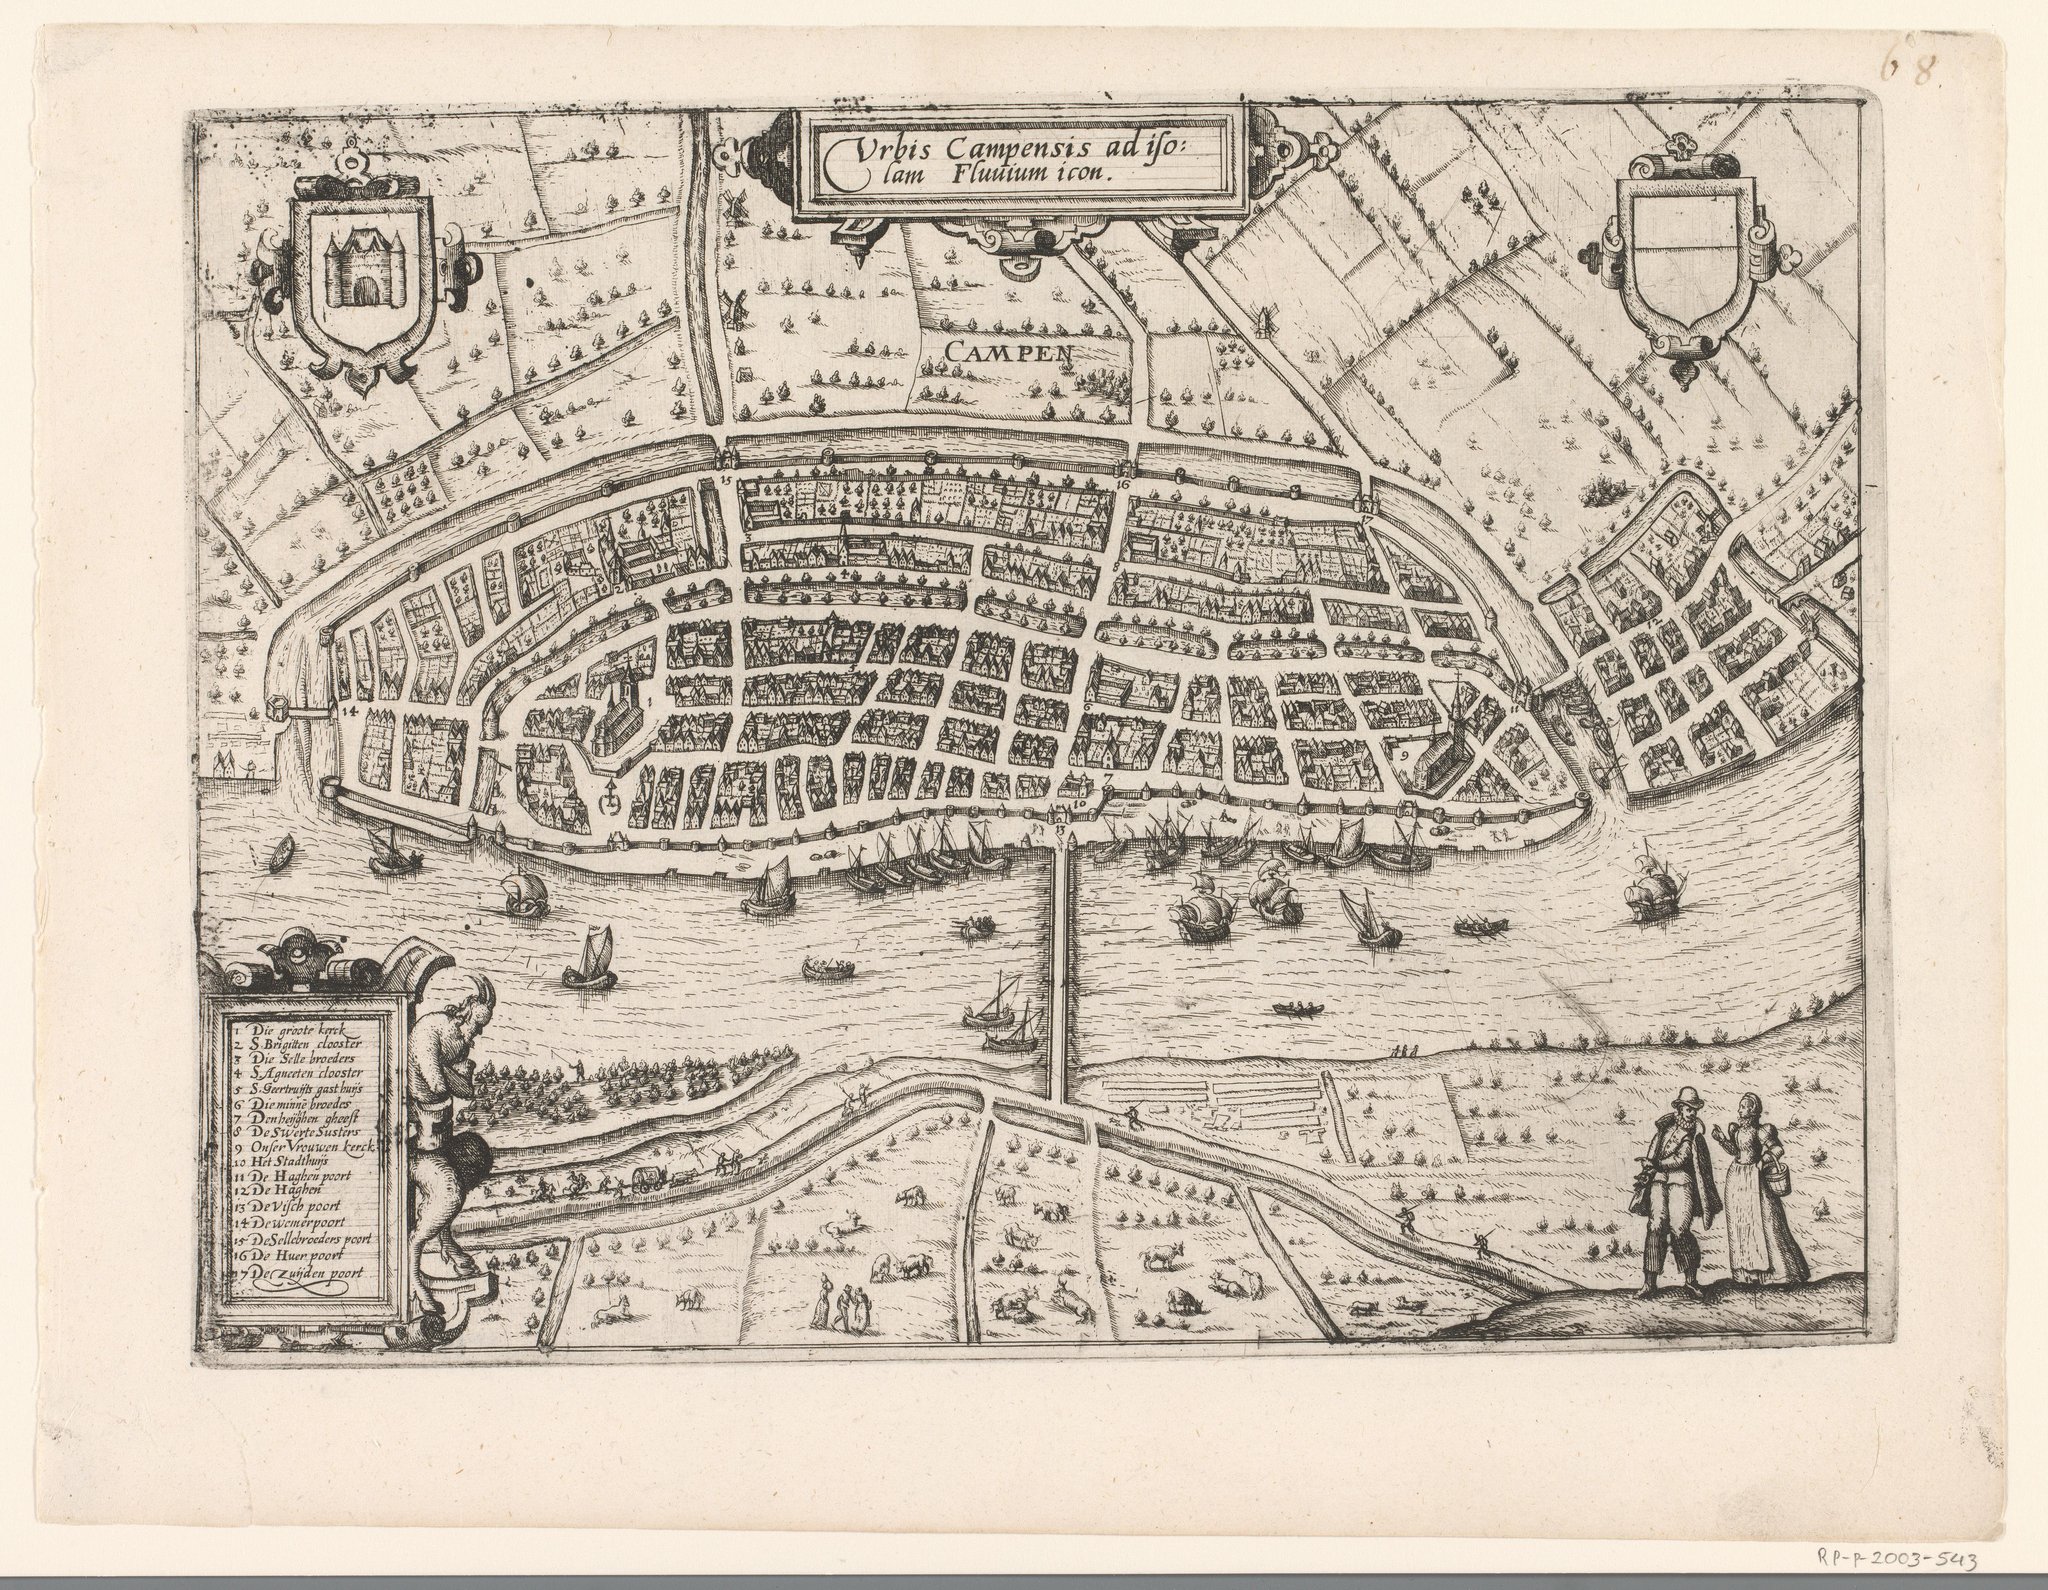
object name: area plan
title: Plattegrond van Kampen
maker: Anonymous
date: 1607-1609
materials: paper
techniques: etching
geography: northern netherlands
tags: satyr(s) (in general), maps of cities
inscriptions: number: ‘68’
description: Plattegrond van de stad Kampen. Midden boven een cartouche met de Latijnse titel, daaronder de Nederlandse titel. Linksboven het stadswapen, rechts een doorsneden wapen. Linksonder een cartouche met een satyr en de legenda 1-17. Rechtsonder een man en een vrouw. Onderdeel van de verzameling kaarten genomen uit een latere editie van: Descrittione di tutti i Paesi Bassi van Lodovico Guicciardini.